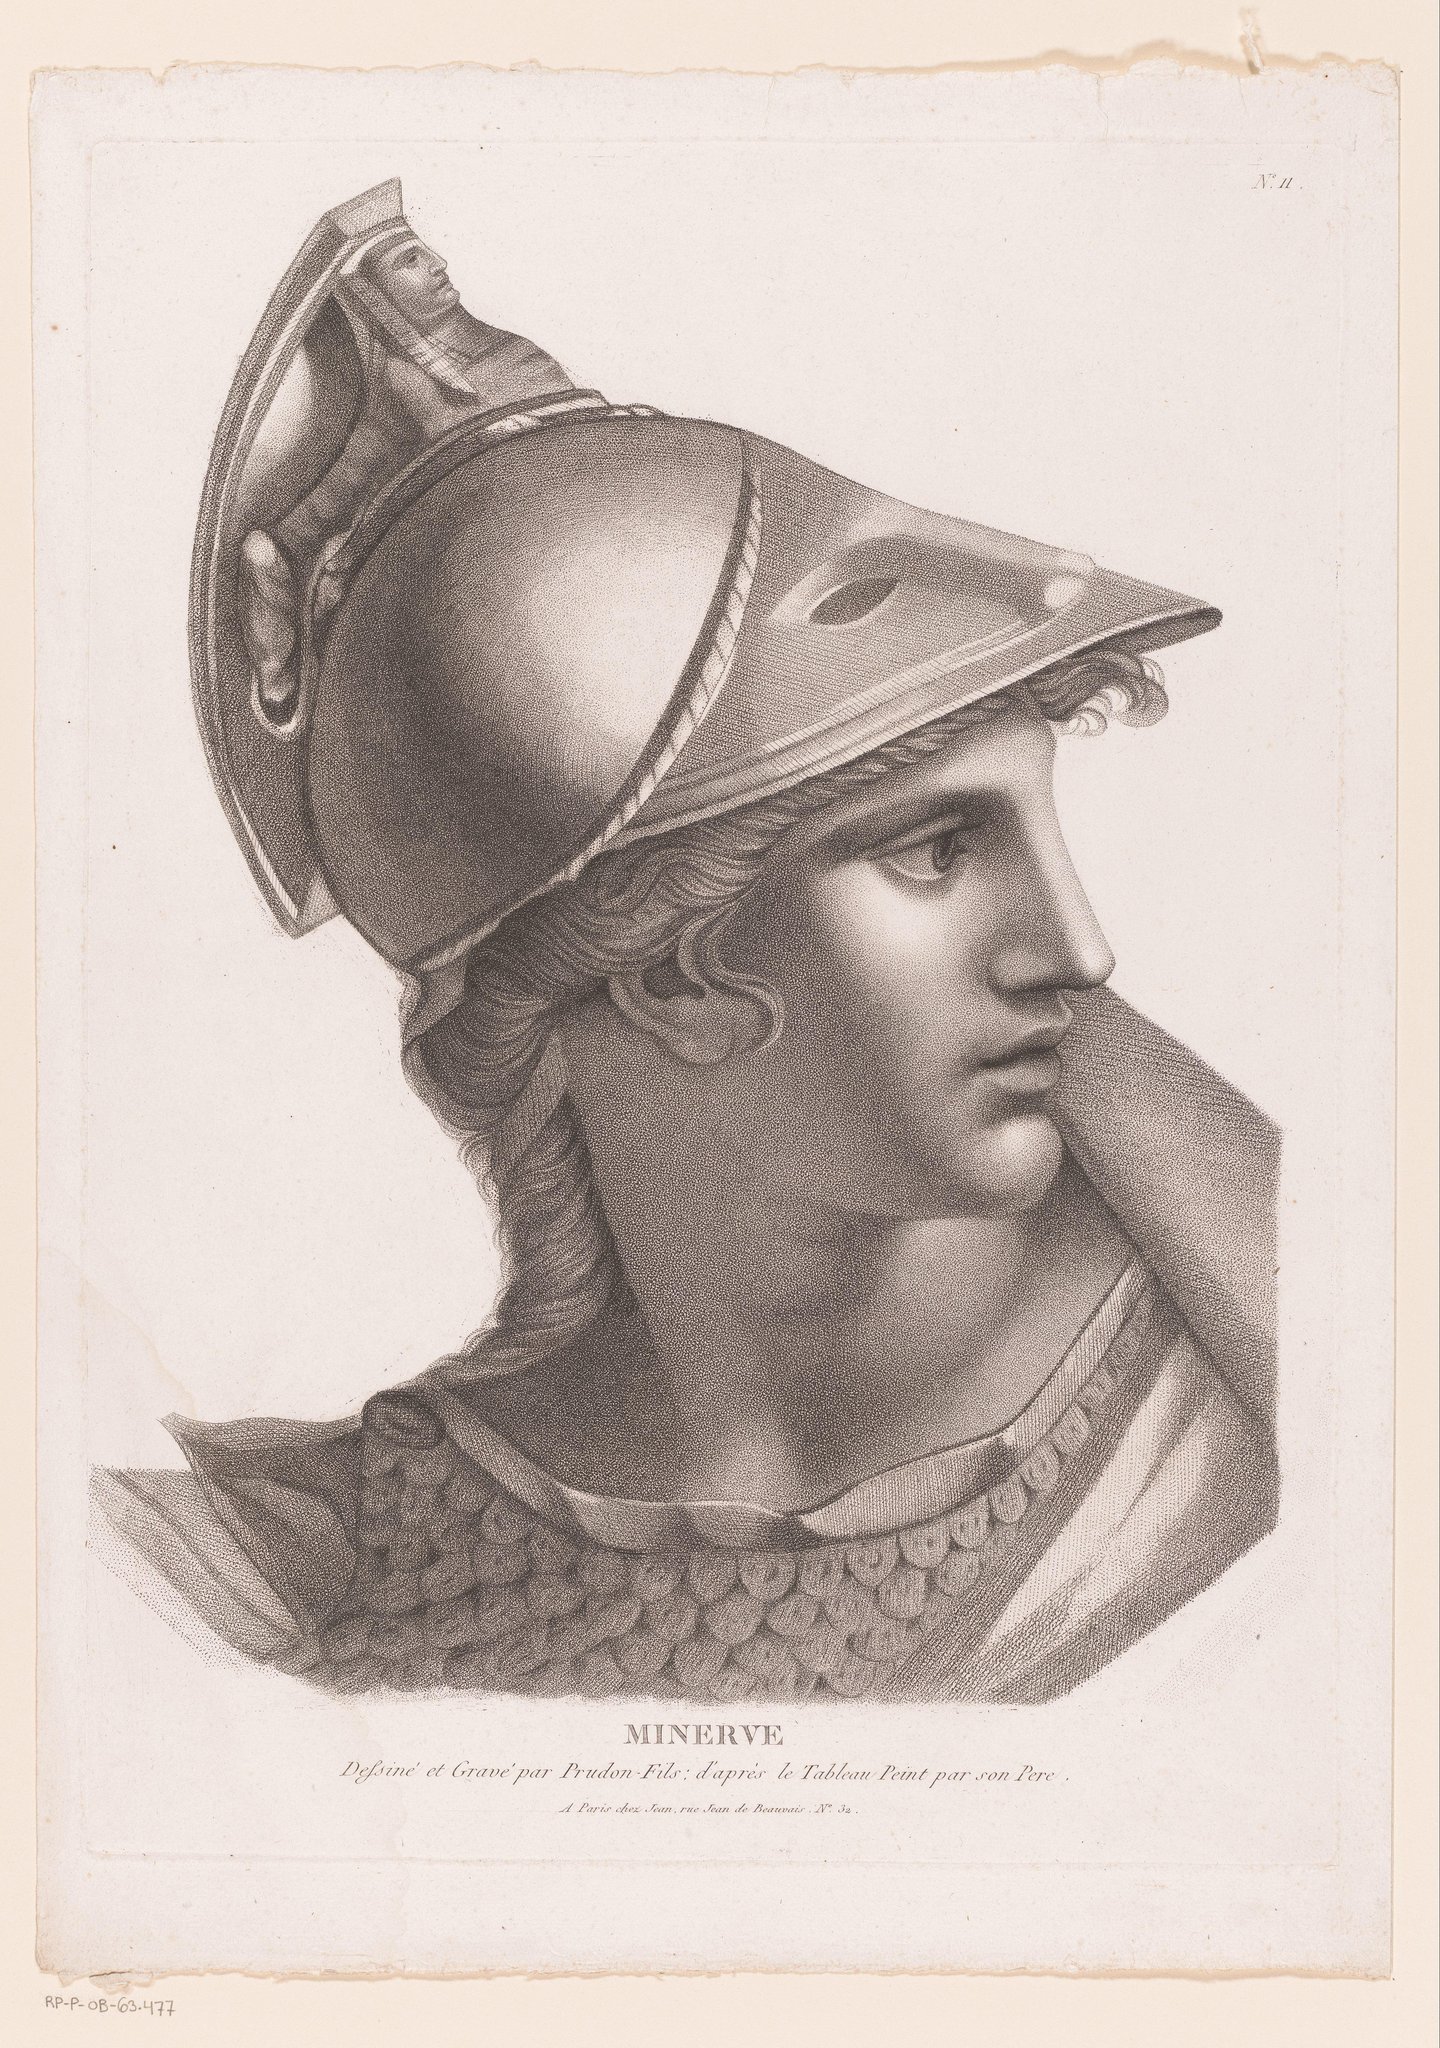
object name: print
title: Hoofd van Minerva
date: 1788-1888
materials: paper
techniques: etching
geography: paris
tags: (story of) minerva (pallas, athena), head turned sideways - aa - female human figure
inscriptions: collector's mark: Lugt 2228